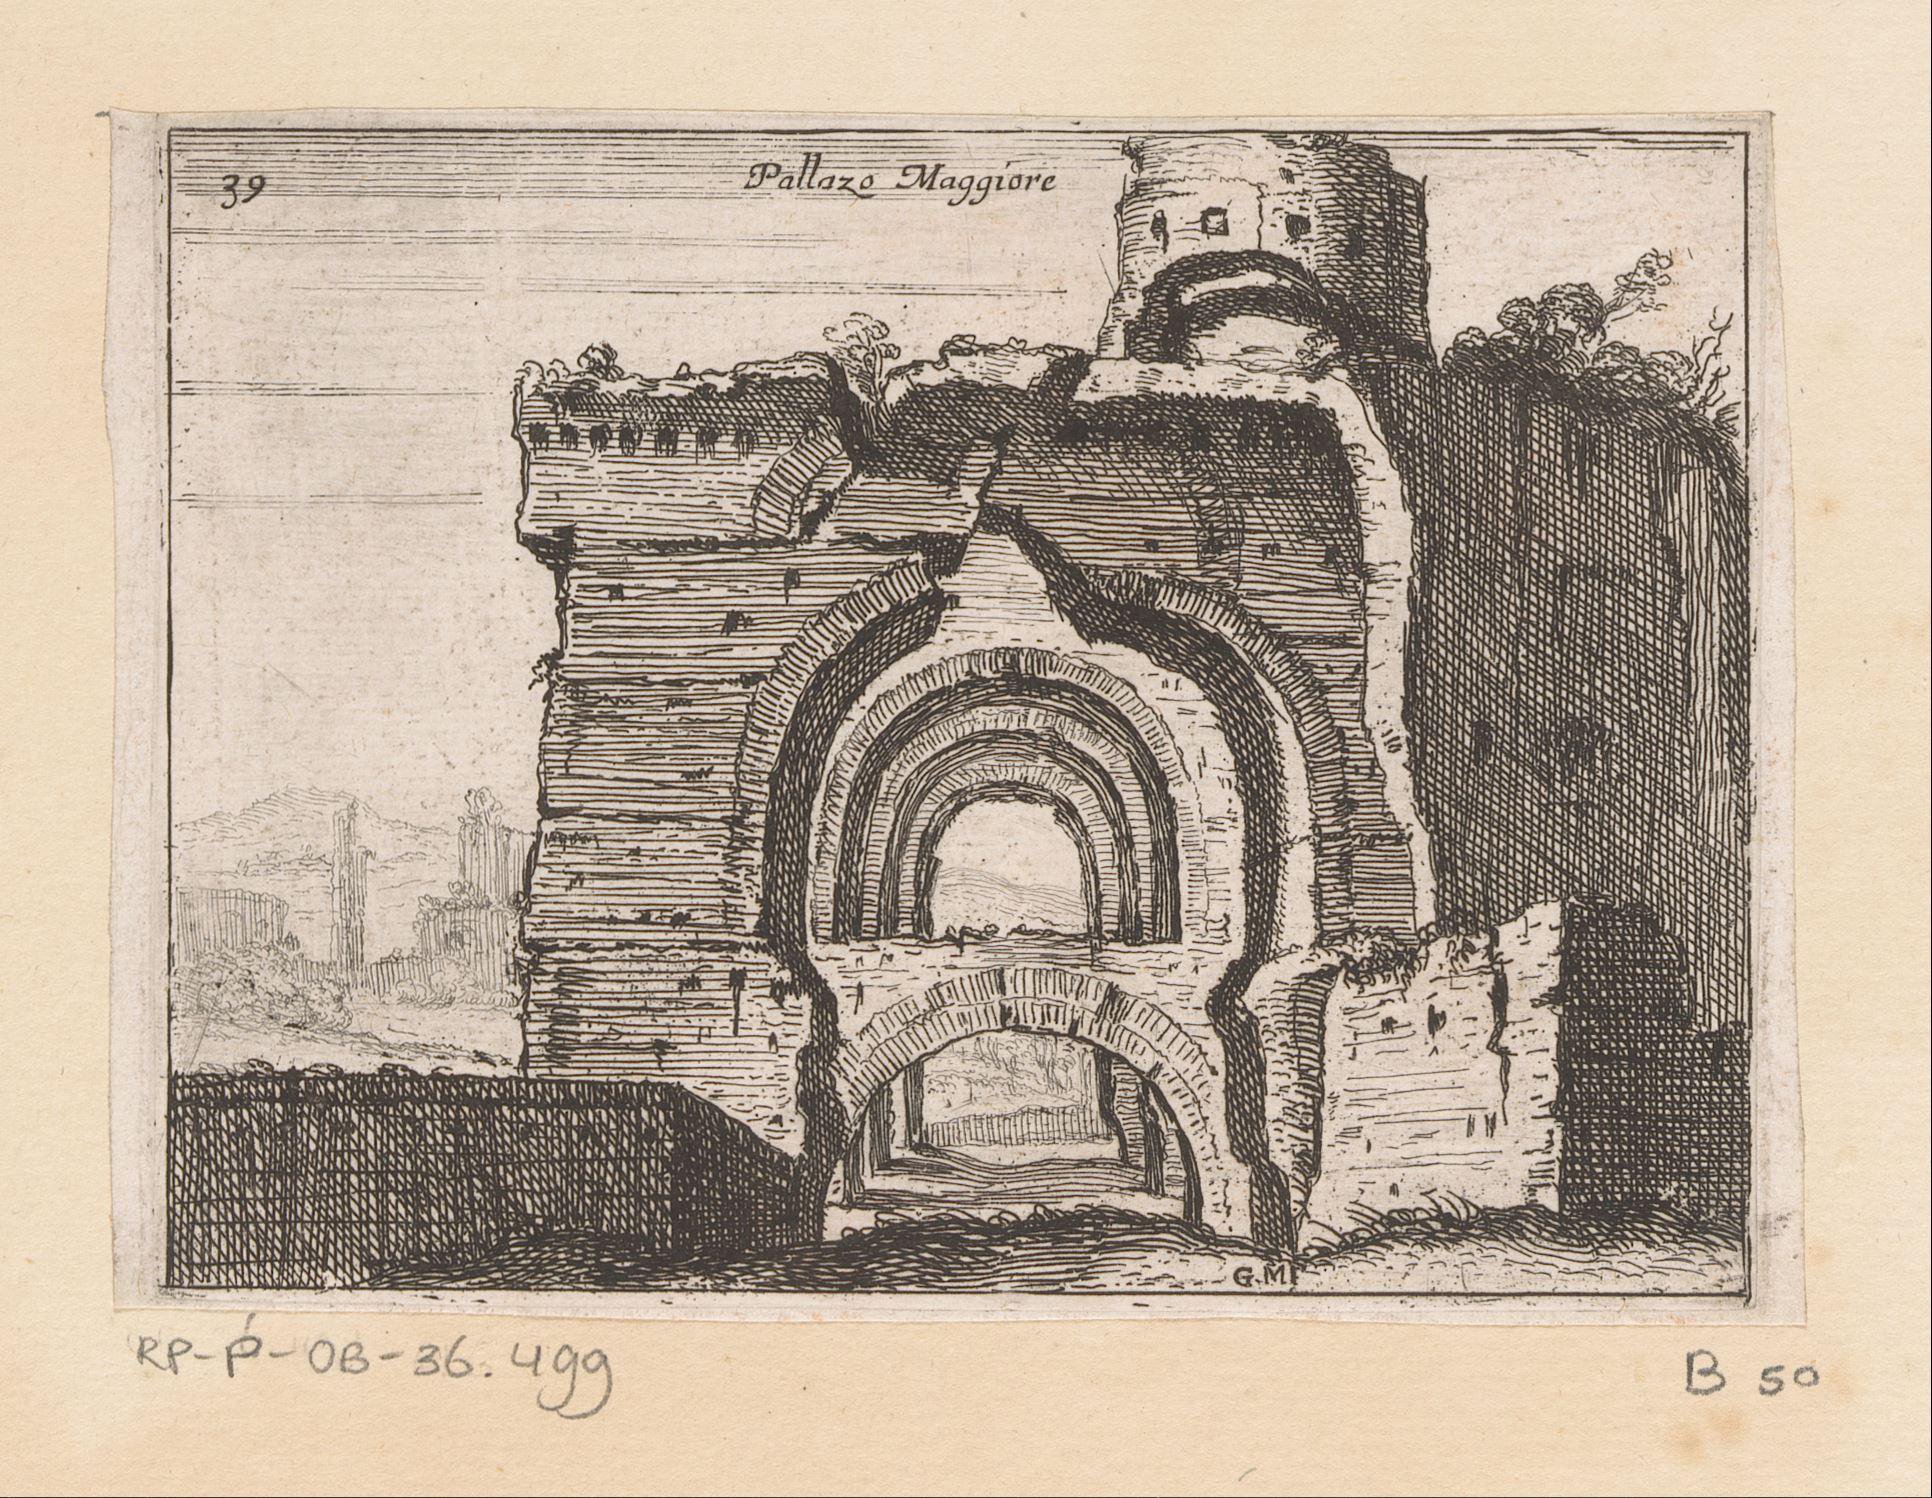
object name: print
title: Palazzo Maggiore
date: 1629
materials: paper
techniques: etching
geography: tuscany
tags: landscape with ruins, rome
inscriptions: collector's mark: Lugt 2228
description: Deze prent maakt deel uit van een reeks van 52 prenten.